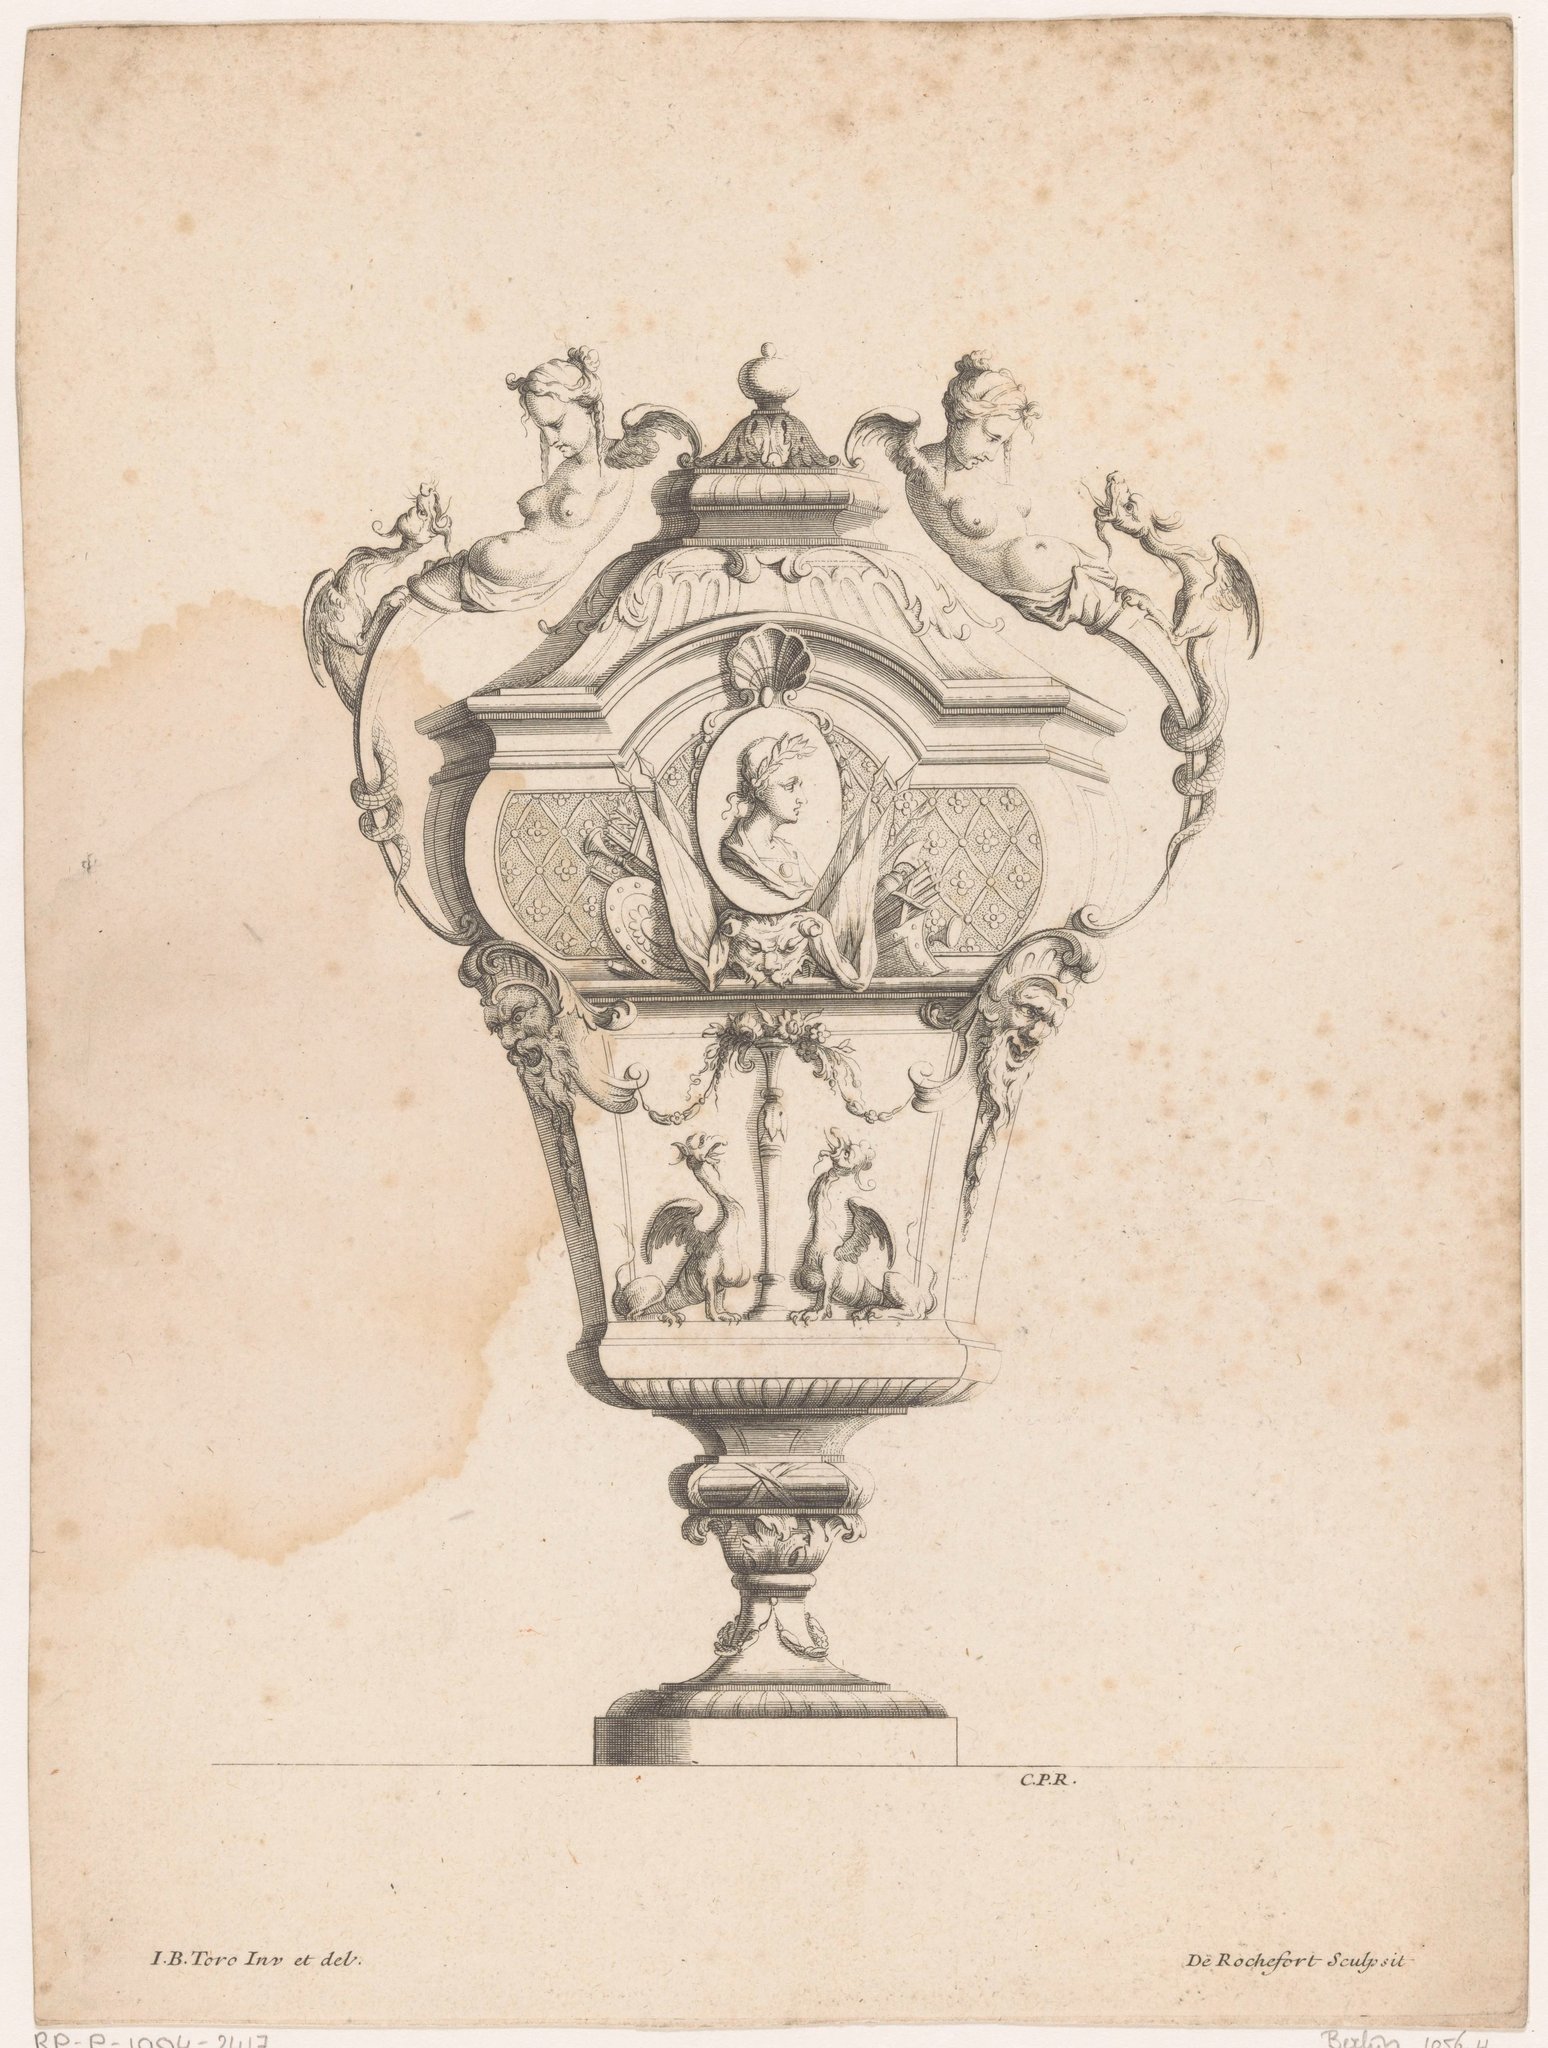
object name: print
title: Vaas met medaillon en halffiguren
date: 1683-1728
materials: paper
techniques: etching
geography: france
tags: ornament ~ medallion, vase ~ ornament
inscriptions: collector's mark: Lugt 2228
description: Een geornamenteerde vaas met twee gevleugelde vrouwelijke halffiguren en draken als handvaten. In het midden een ovaal medaillon met gelauwerd portret en profil en vlaggen, wapens en een leeuwenkop. Daaronder twee maskers, een vaas en twee draken.